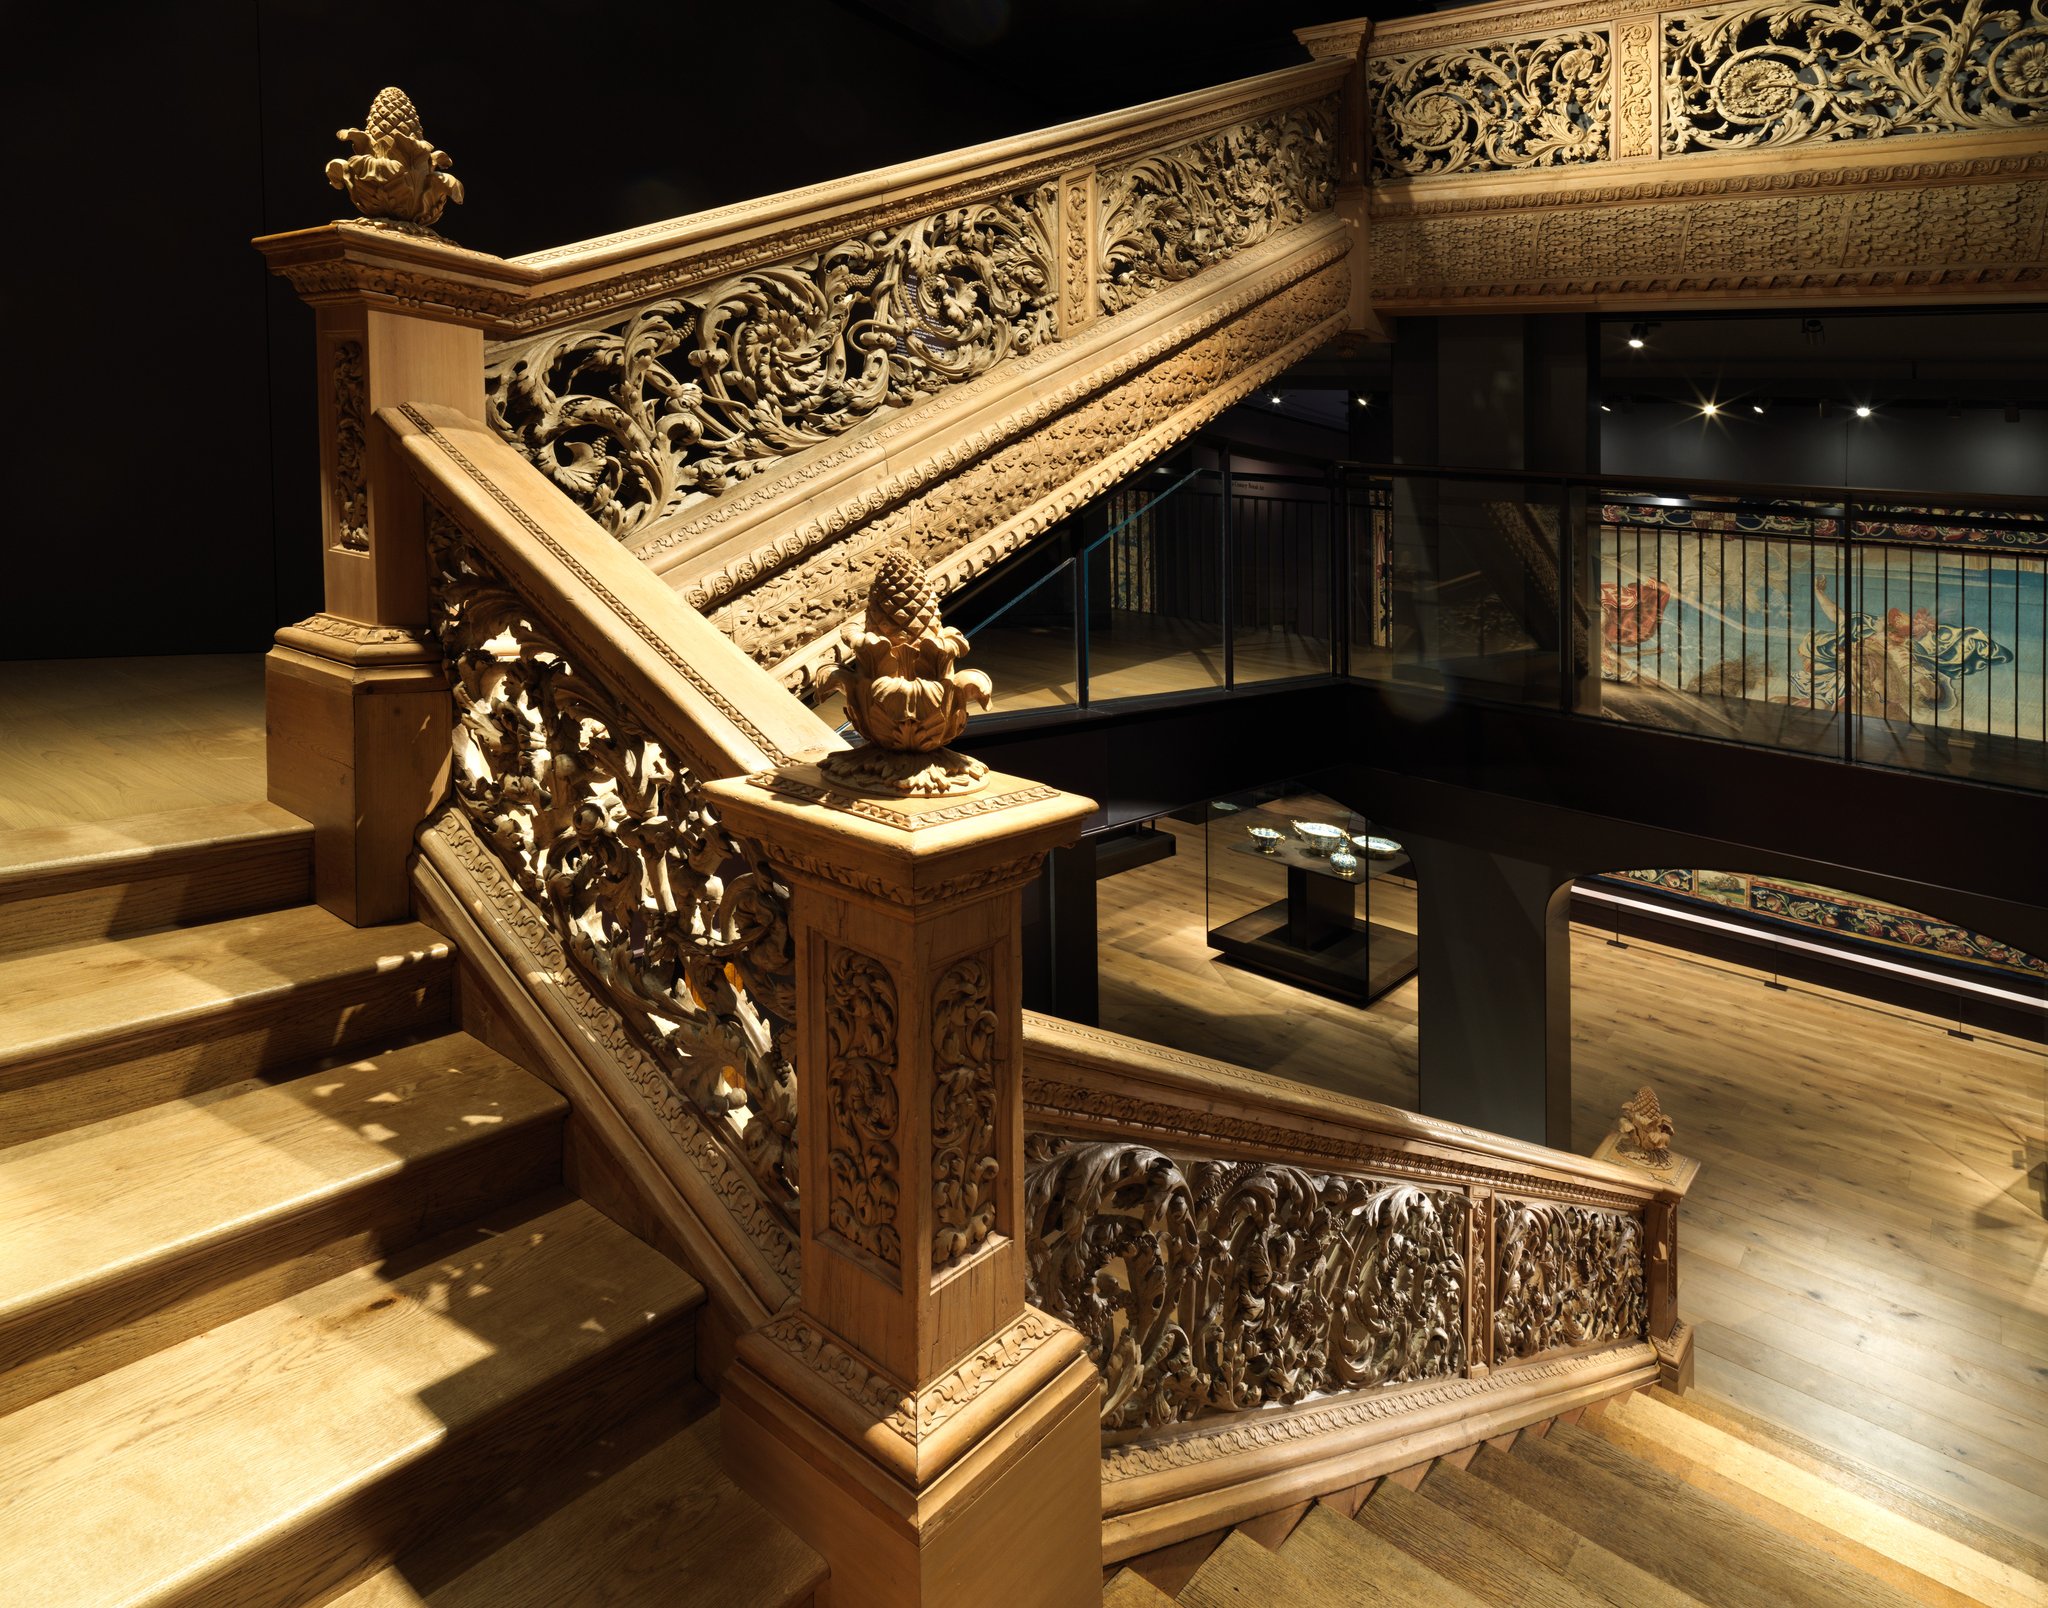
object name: stair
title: Staircase from Cassiobury Park, Hertfordshire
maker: edward pearce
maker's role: maker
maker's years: 1630-1695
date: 1677-1680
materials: wood